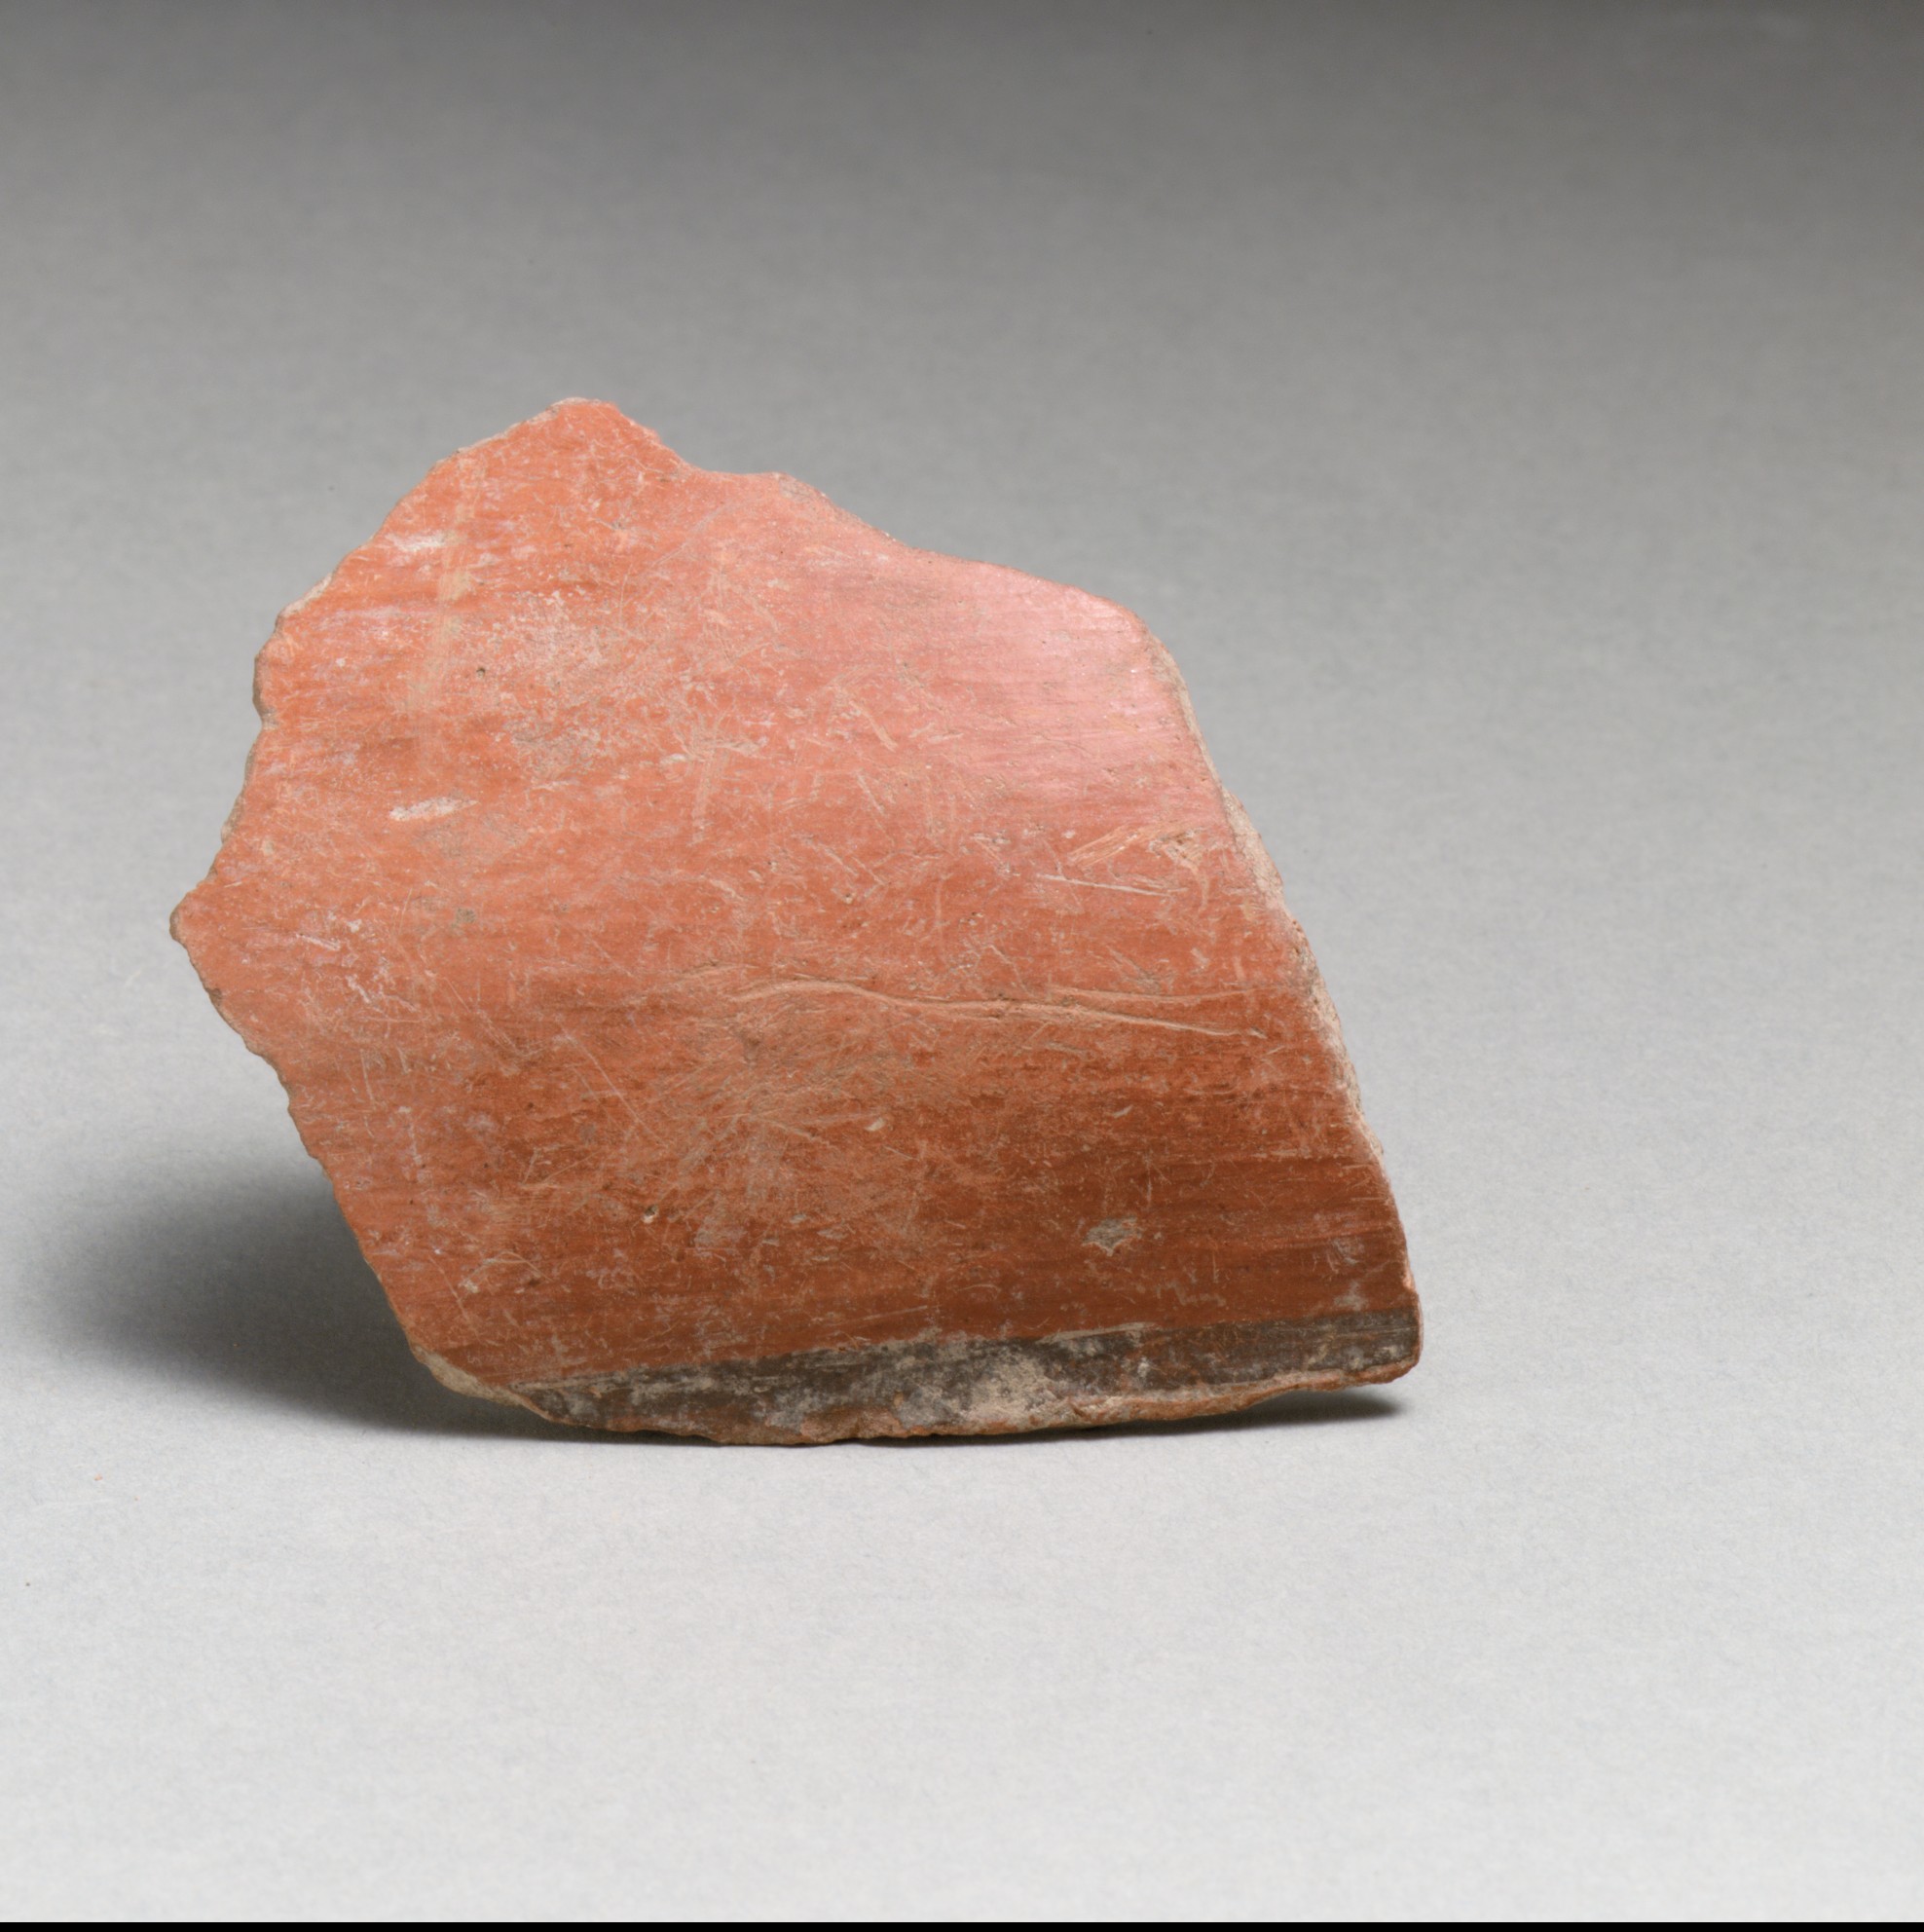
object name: vase fragment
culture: neolithic, thessaly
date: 4000-3000 BCE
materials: terracotta